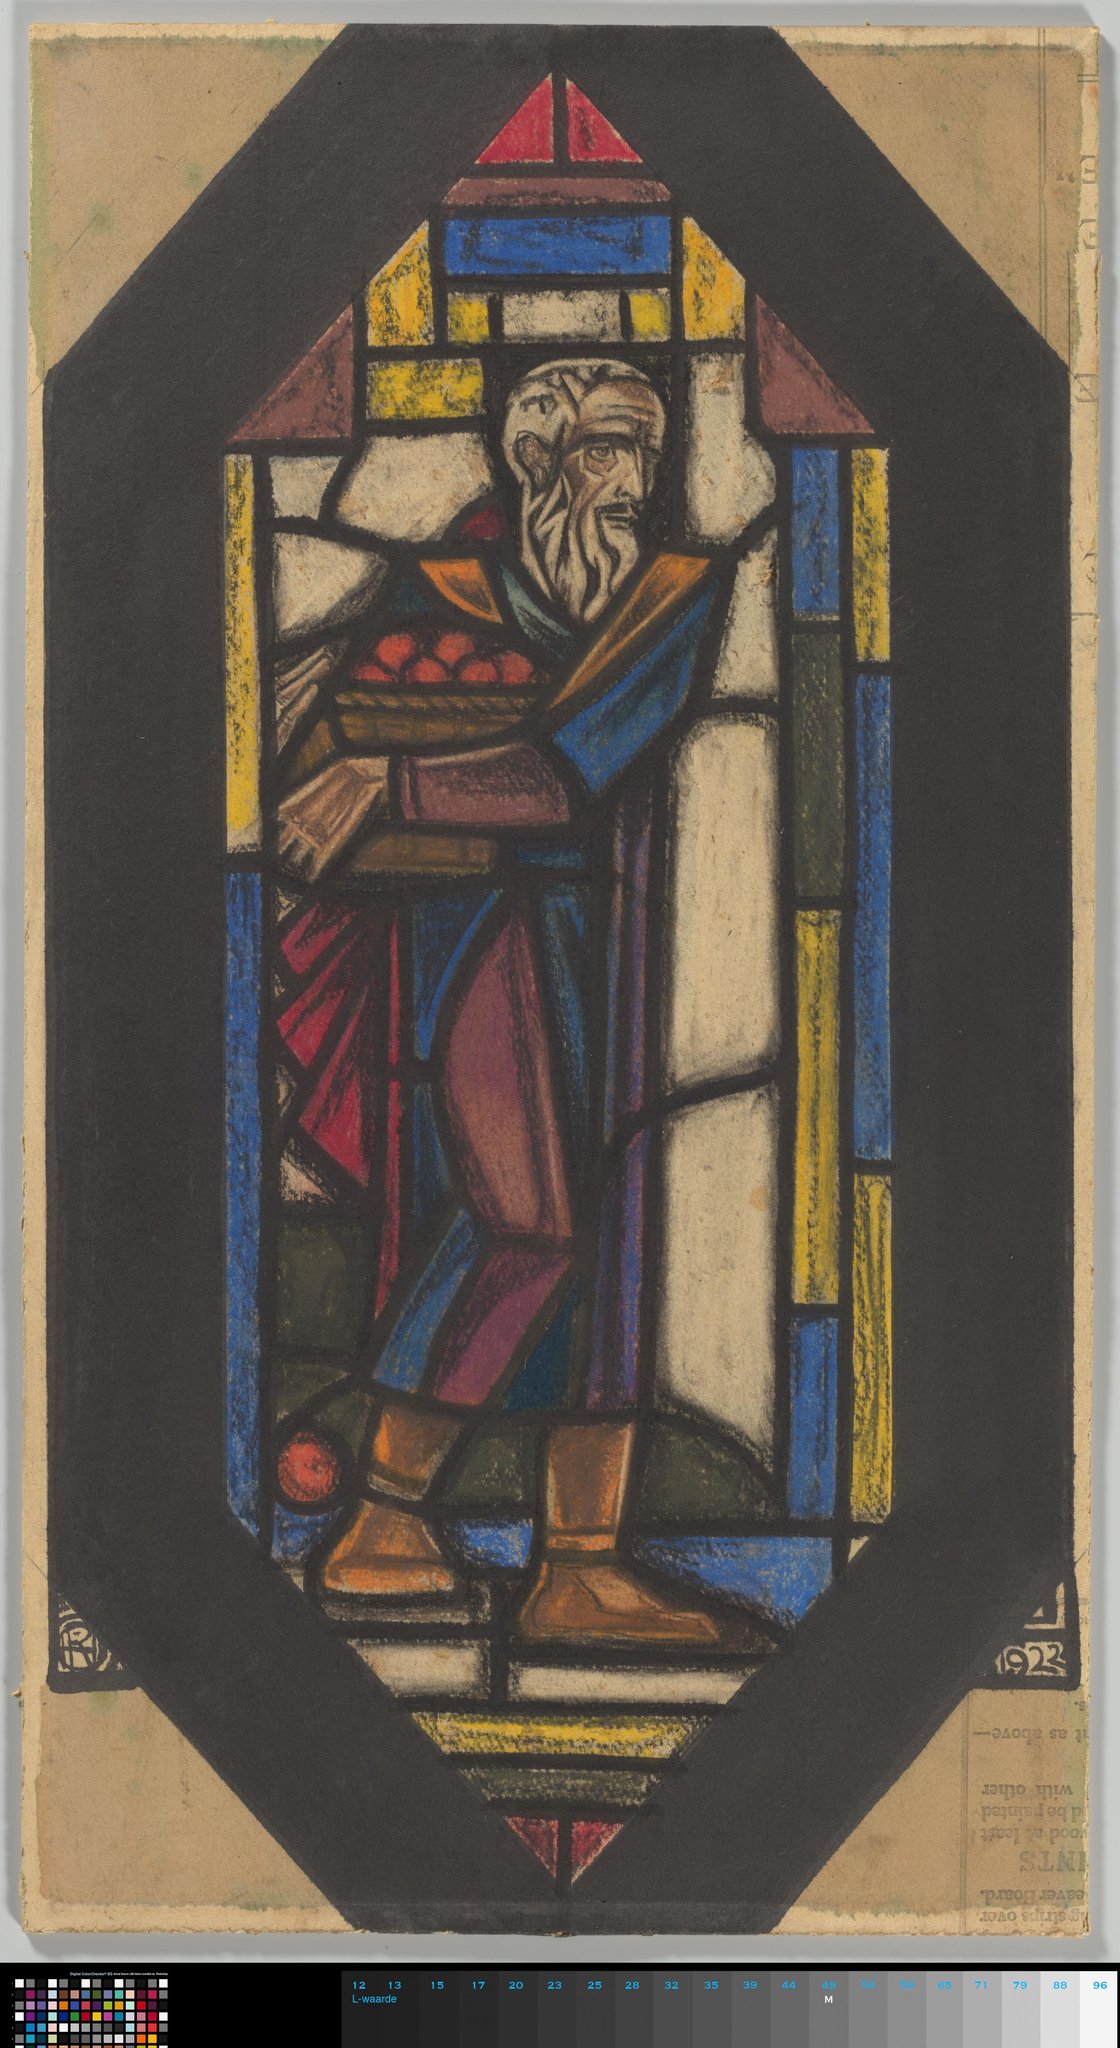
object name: design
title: De trap des levens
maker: richard nicolaüs roland holst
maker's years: 1868-1938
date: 1922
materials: cardboard, chalk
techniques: brush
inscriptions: monogram: ‘RNRH’